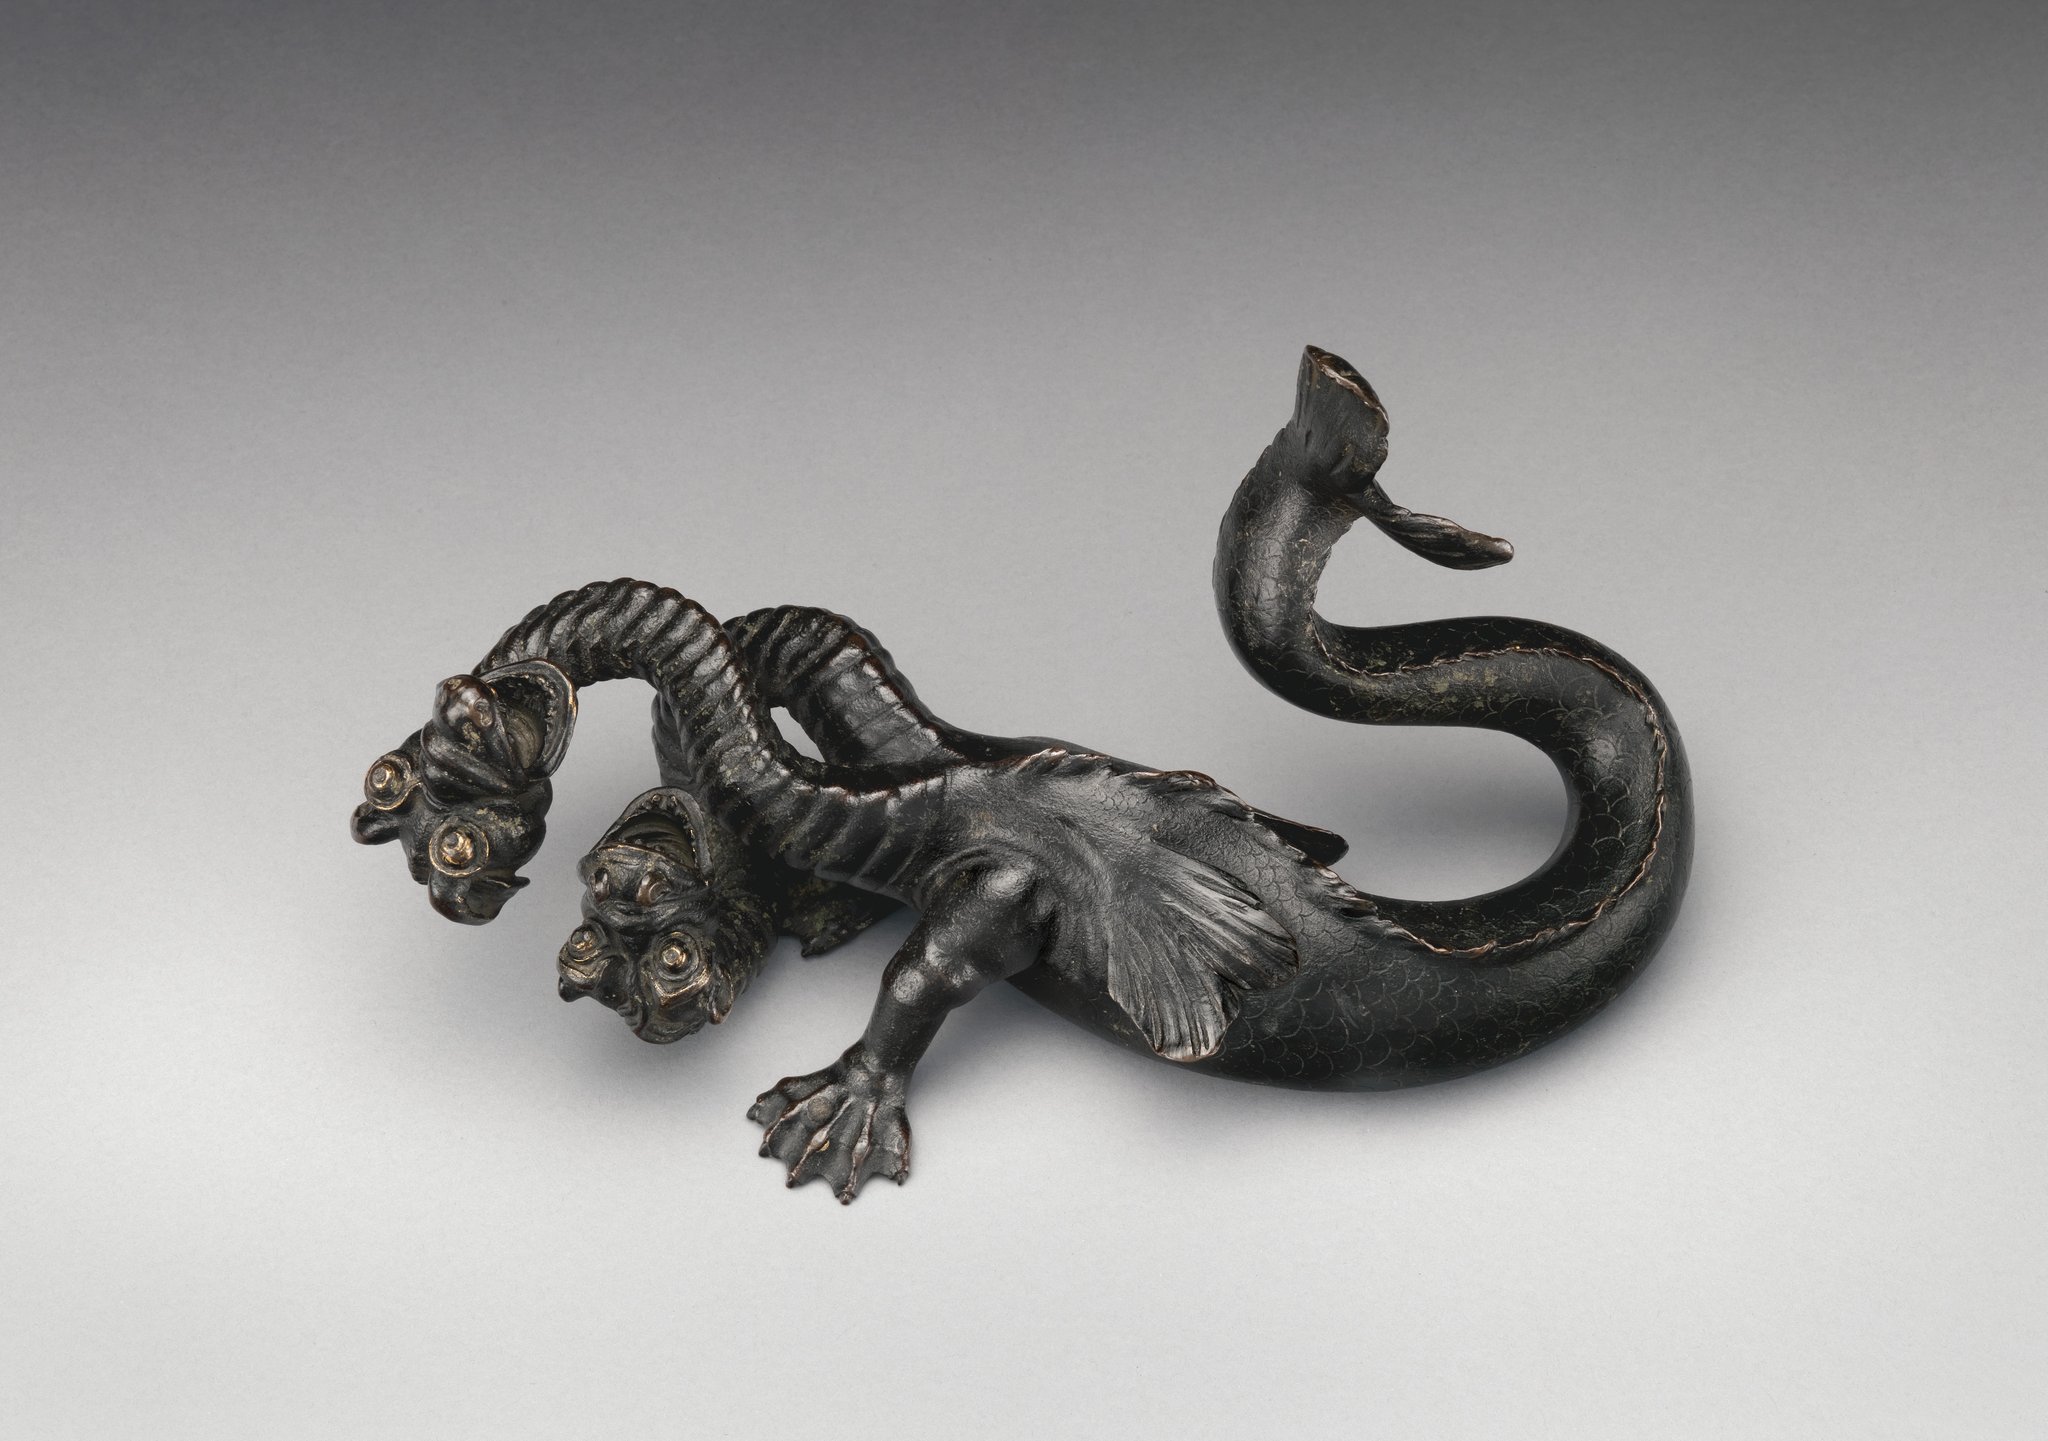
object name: statuette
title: Pair of double-headed monsters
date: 1667-1700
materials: bronze, lacquer, patina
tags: monsters